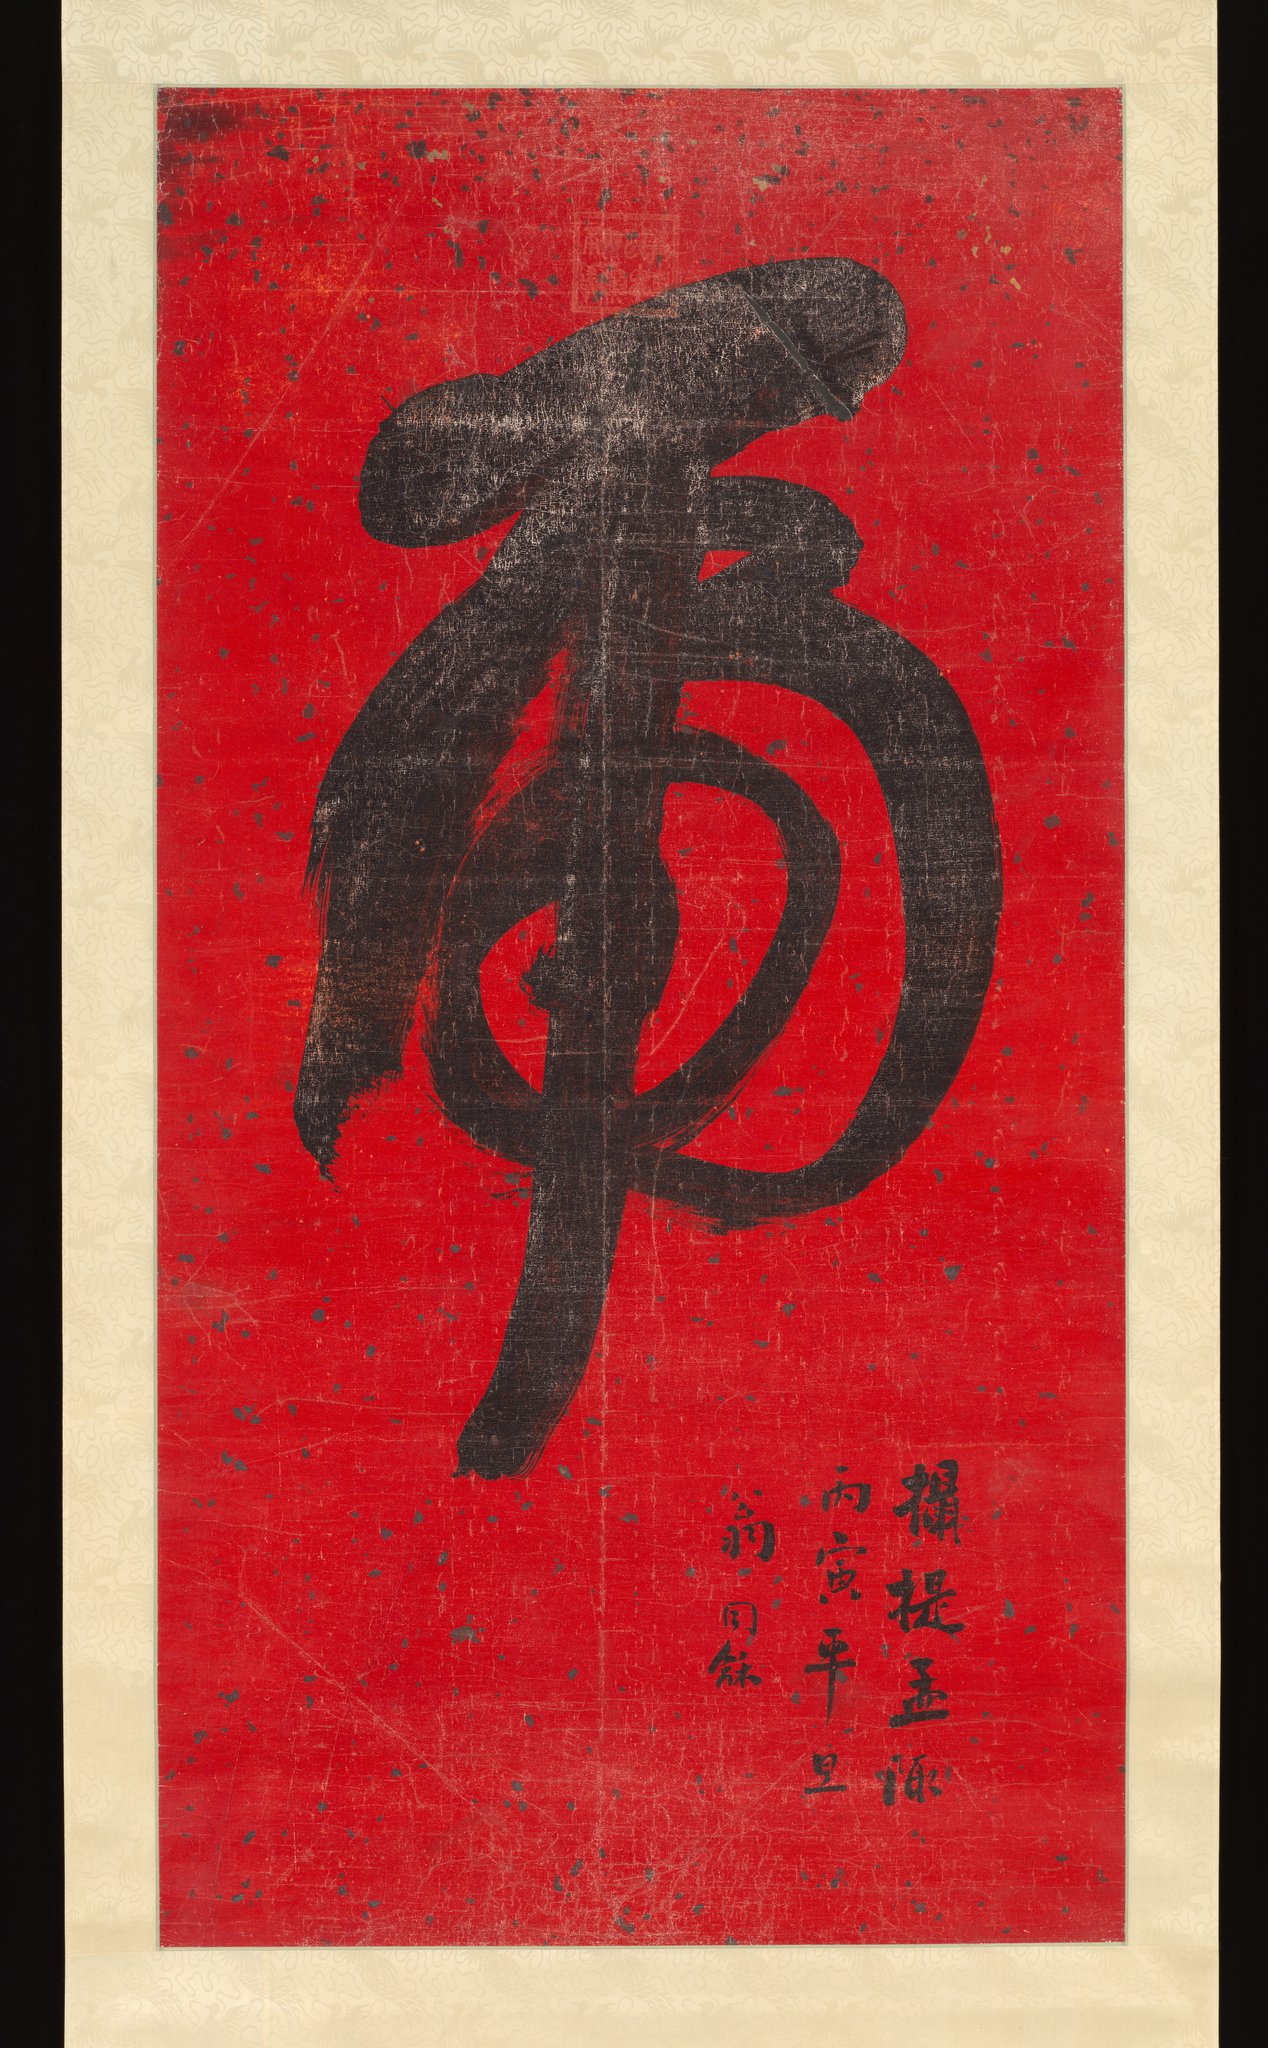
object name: hanging scroll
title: Tiger Calligraphy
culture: chinese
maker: weng tonghe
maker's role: artist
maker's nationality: chinese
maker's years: 1830-1904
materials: ink, paper, silver